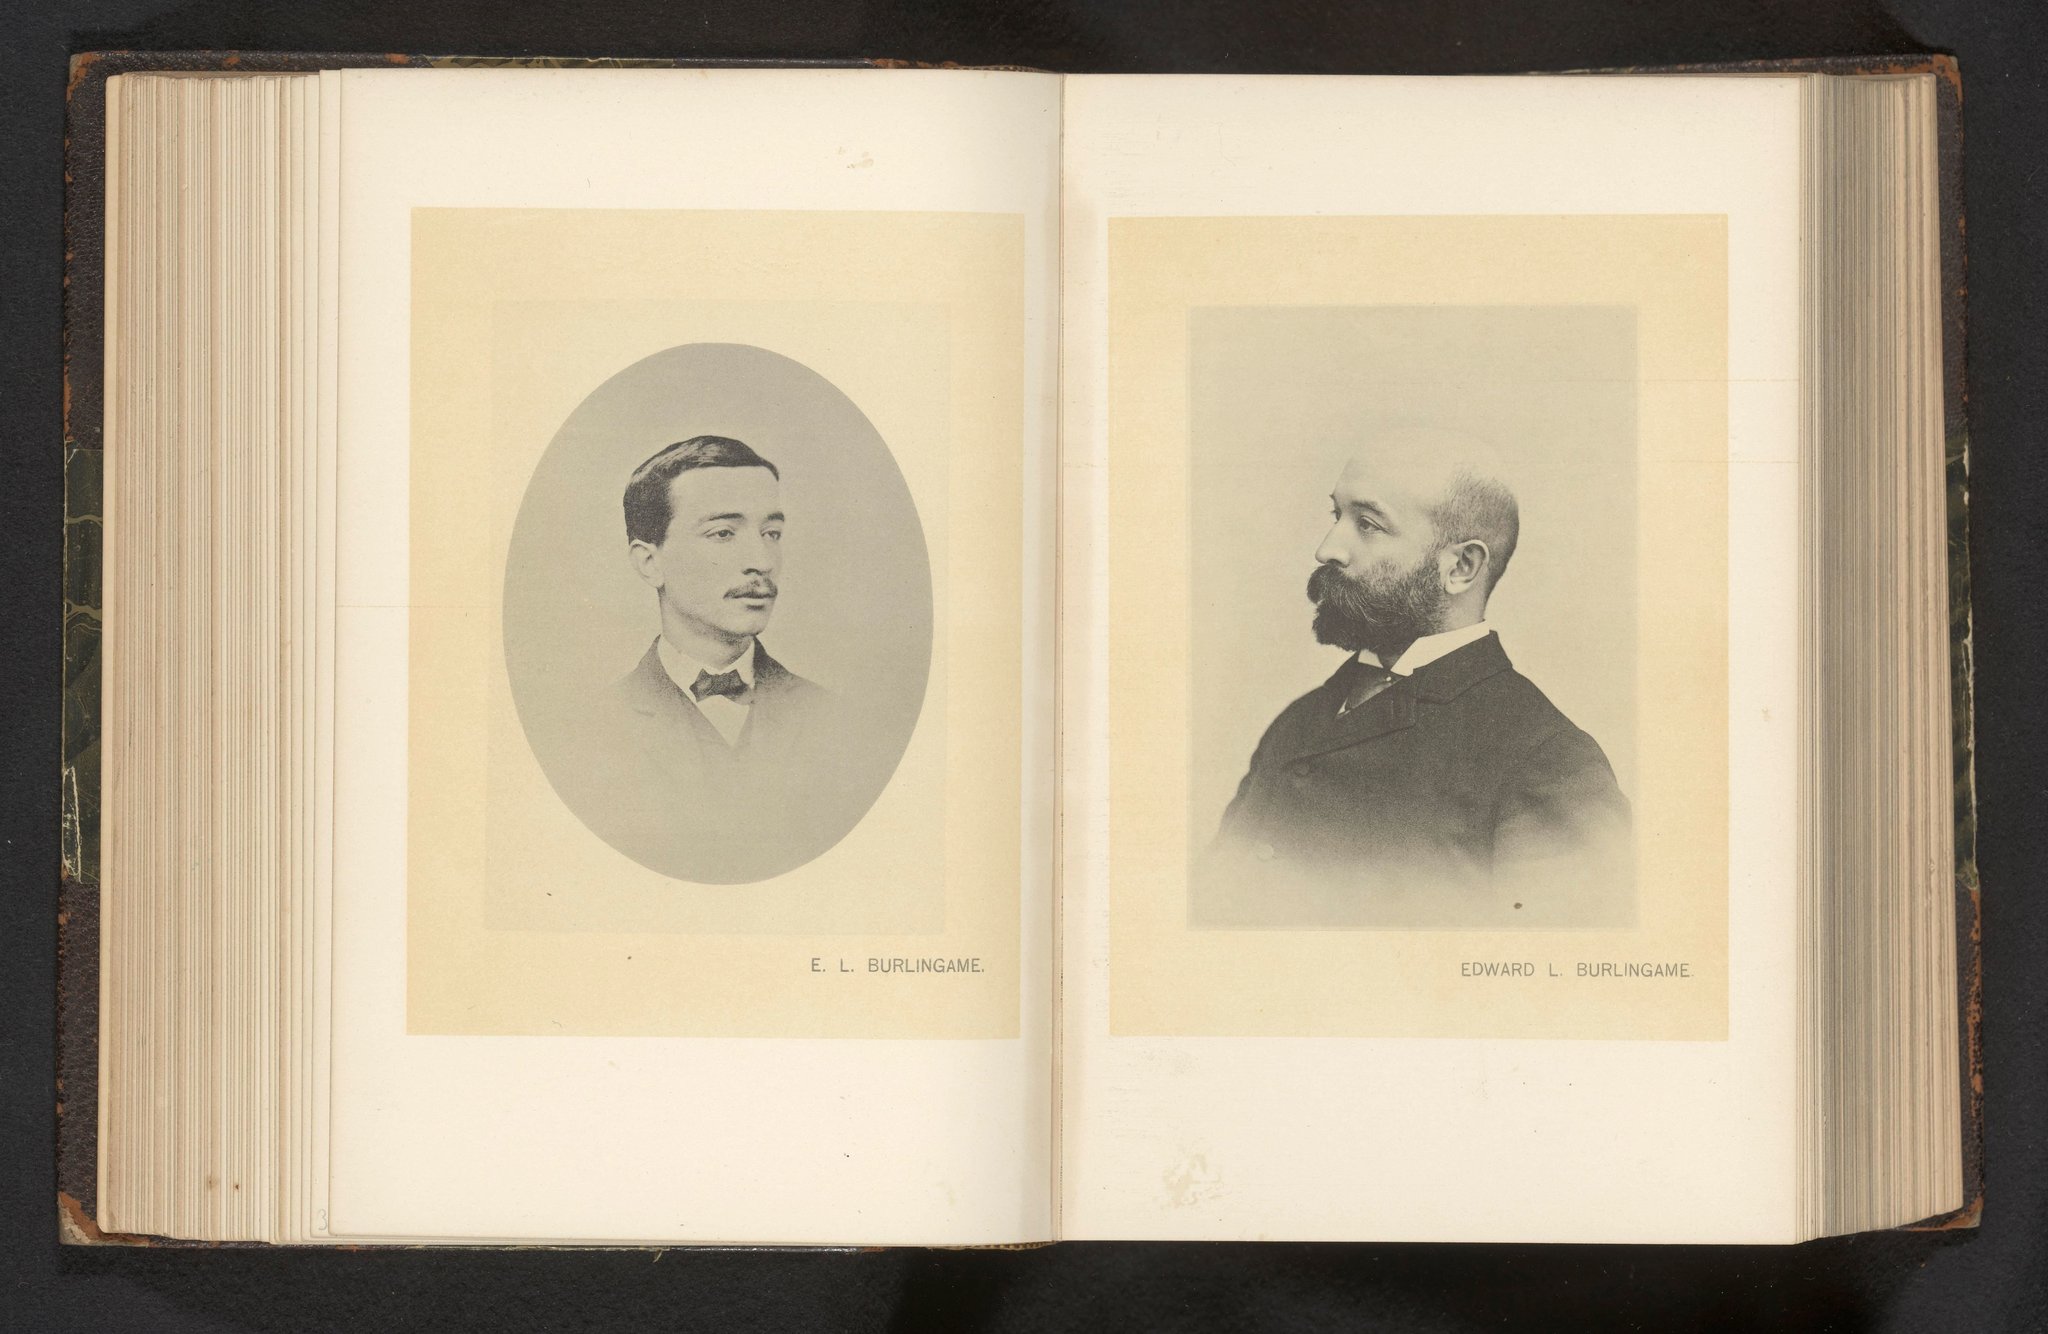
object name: page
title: Edward L. Burlingame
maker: Anonymous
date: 1889-1894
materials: paper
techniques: photoaquatint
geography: boston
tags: adult man